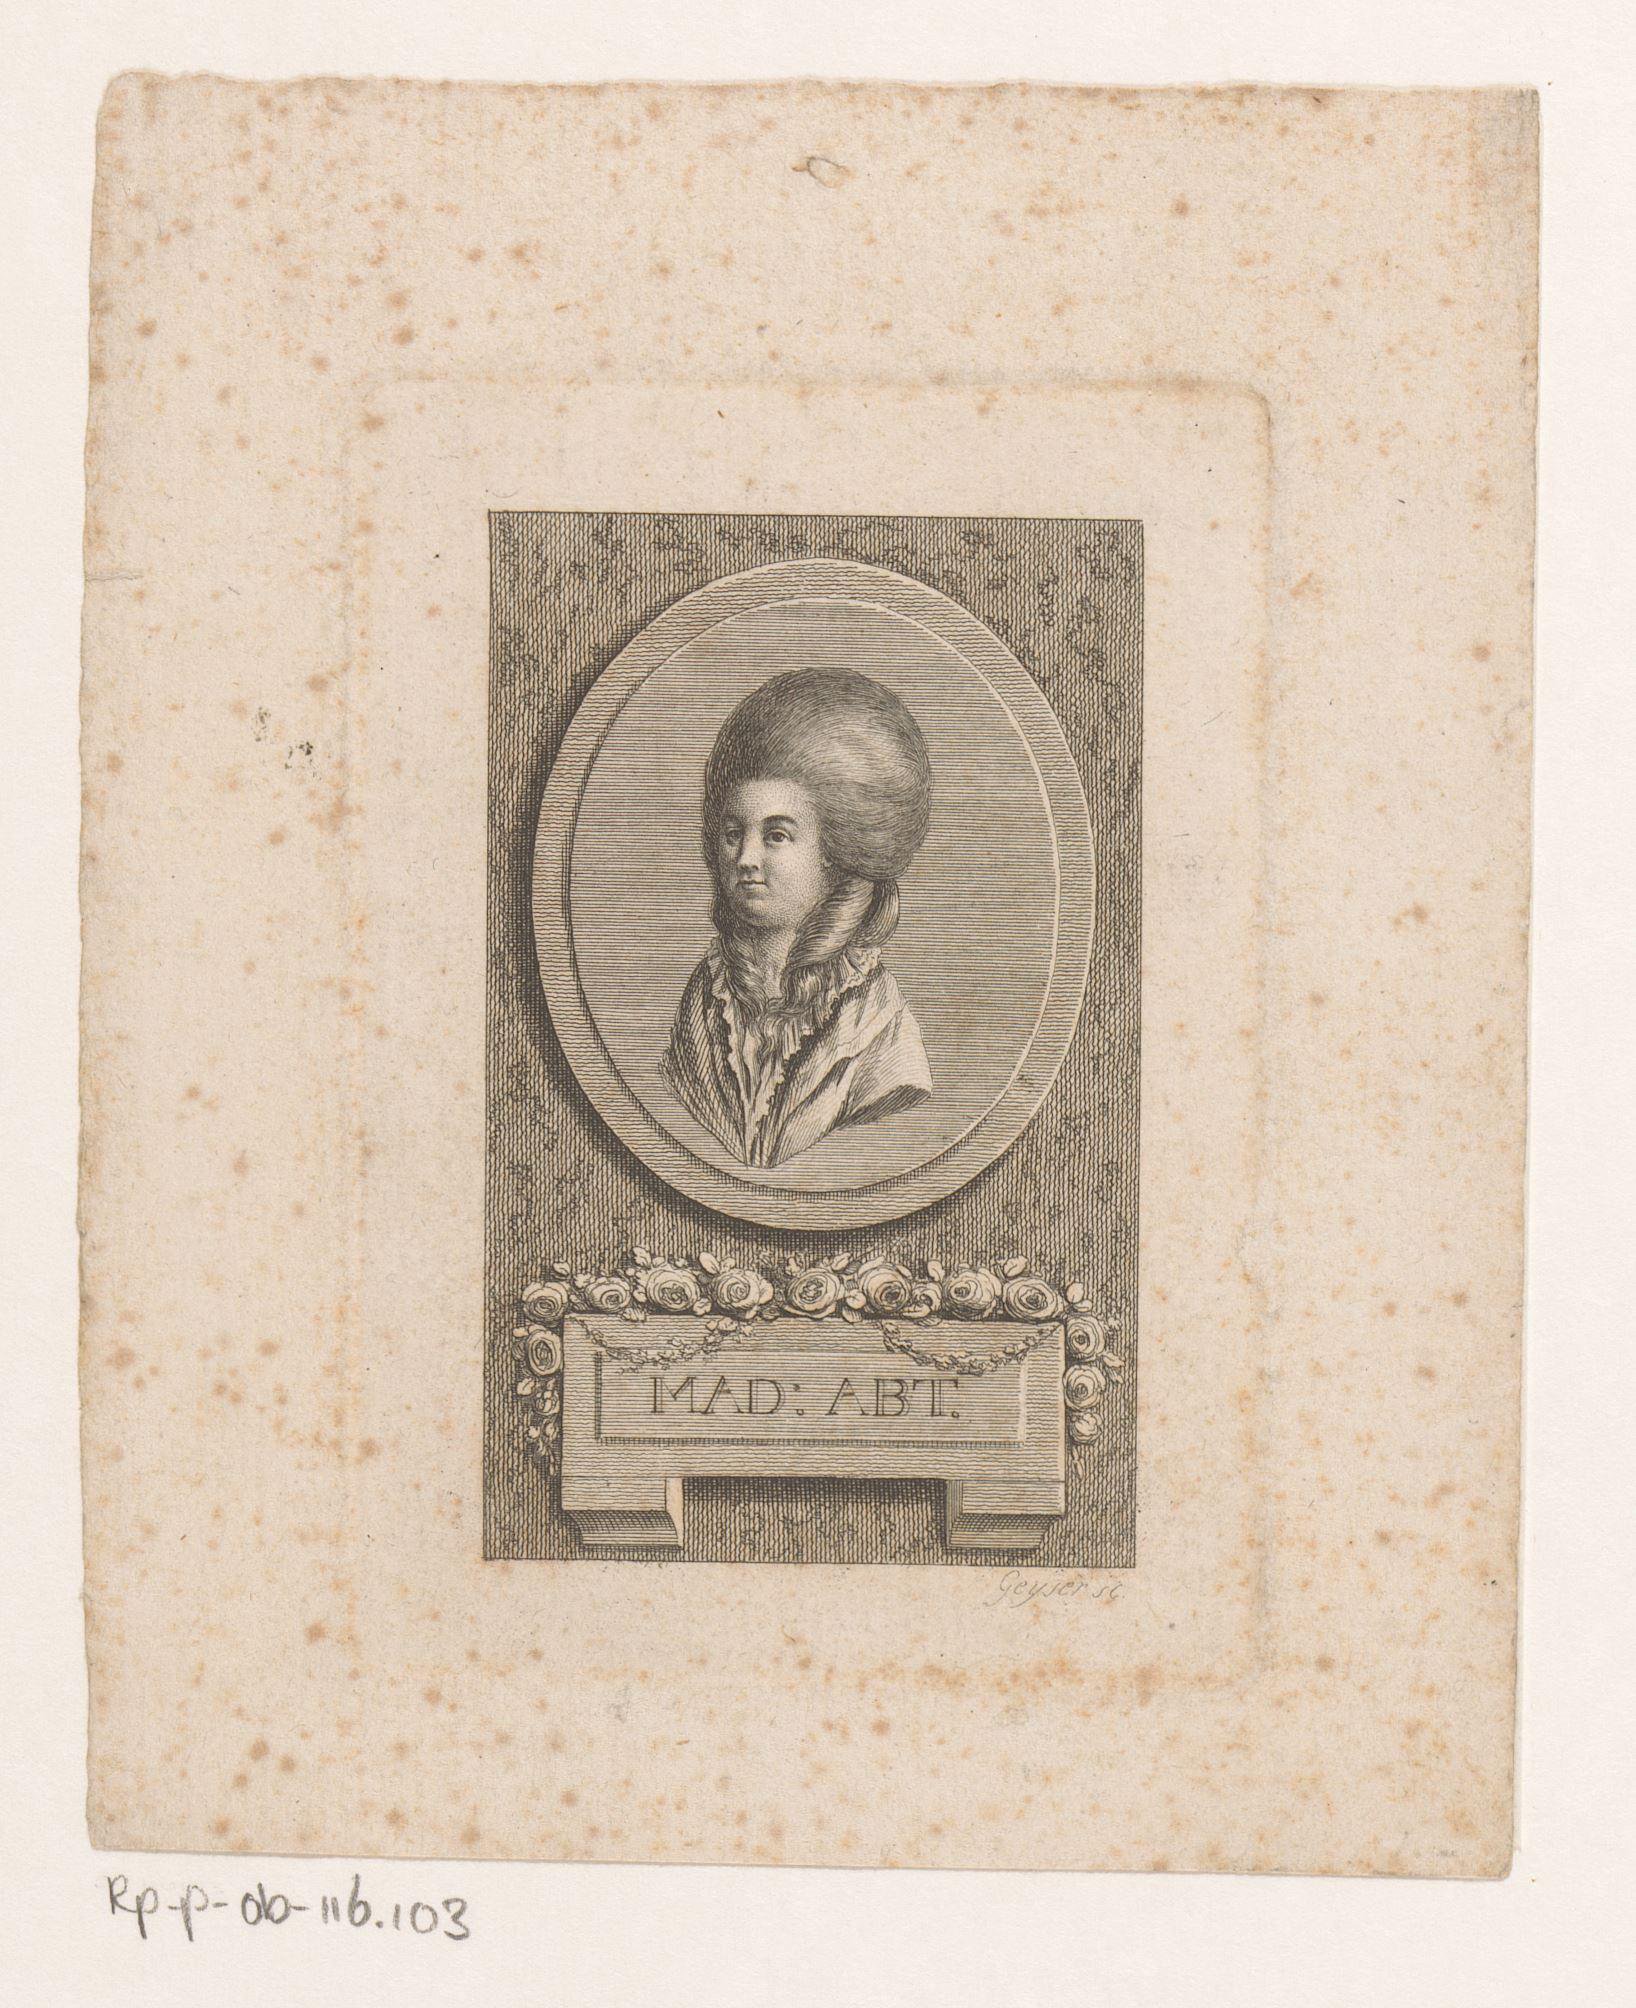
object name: print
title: Portret van Felicitas Abt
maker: christian gottlieb geyser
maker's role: print maker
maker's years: 1742-1803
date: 1752-1803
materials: paper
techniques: engraving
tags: garland, wreath, historical persons - bb - woman, ornament ~ medallion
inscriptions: collector's mark: Lugt 2228, collector's mark: Lugt 1388